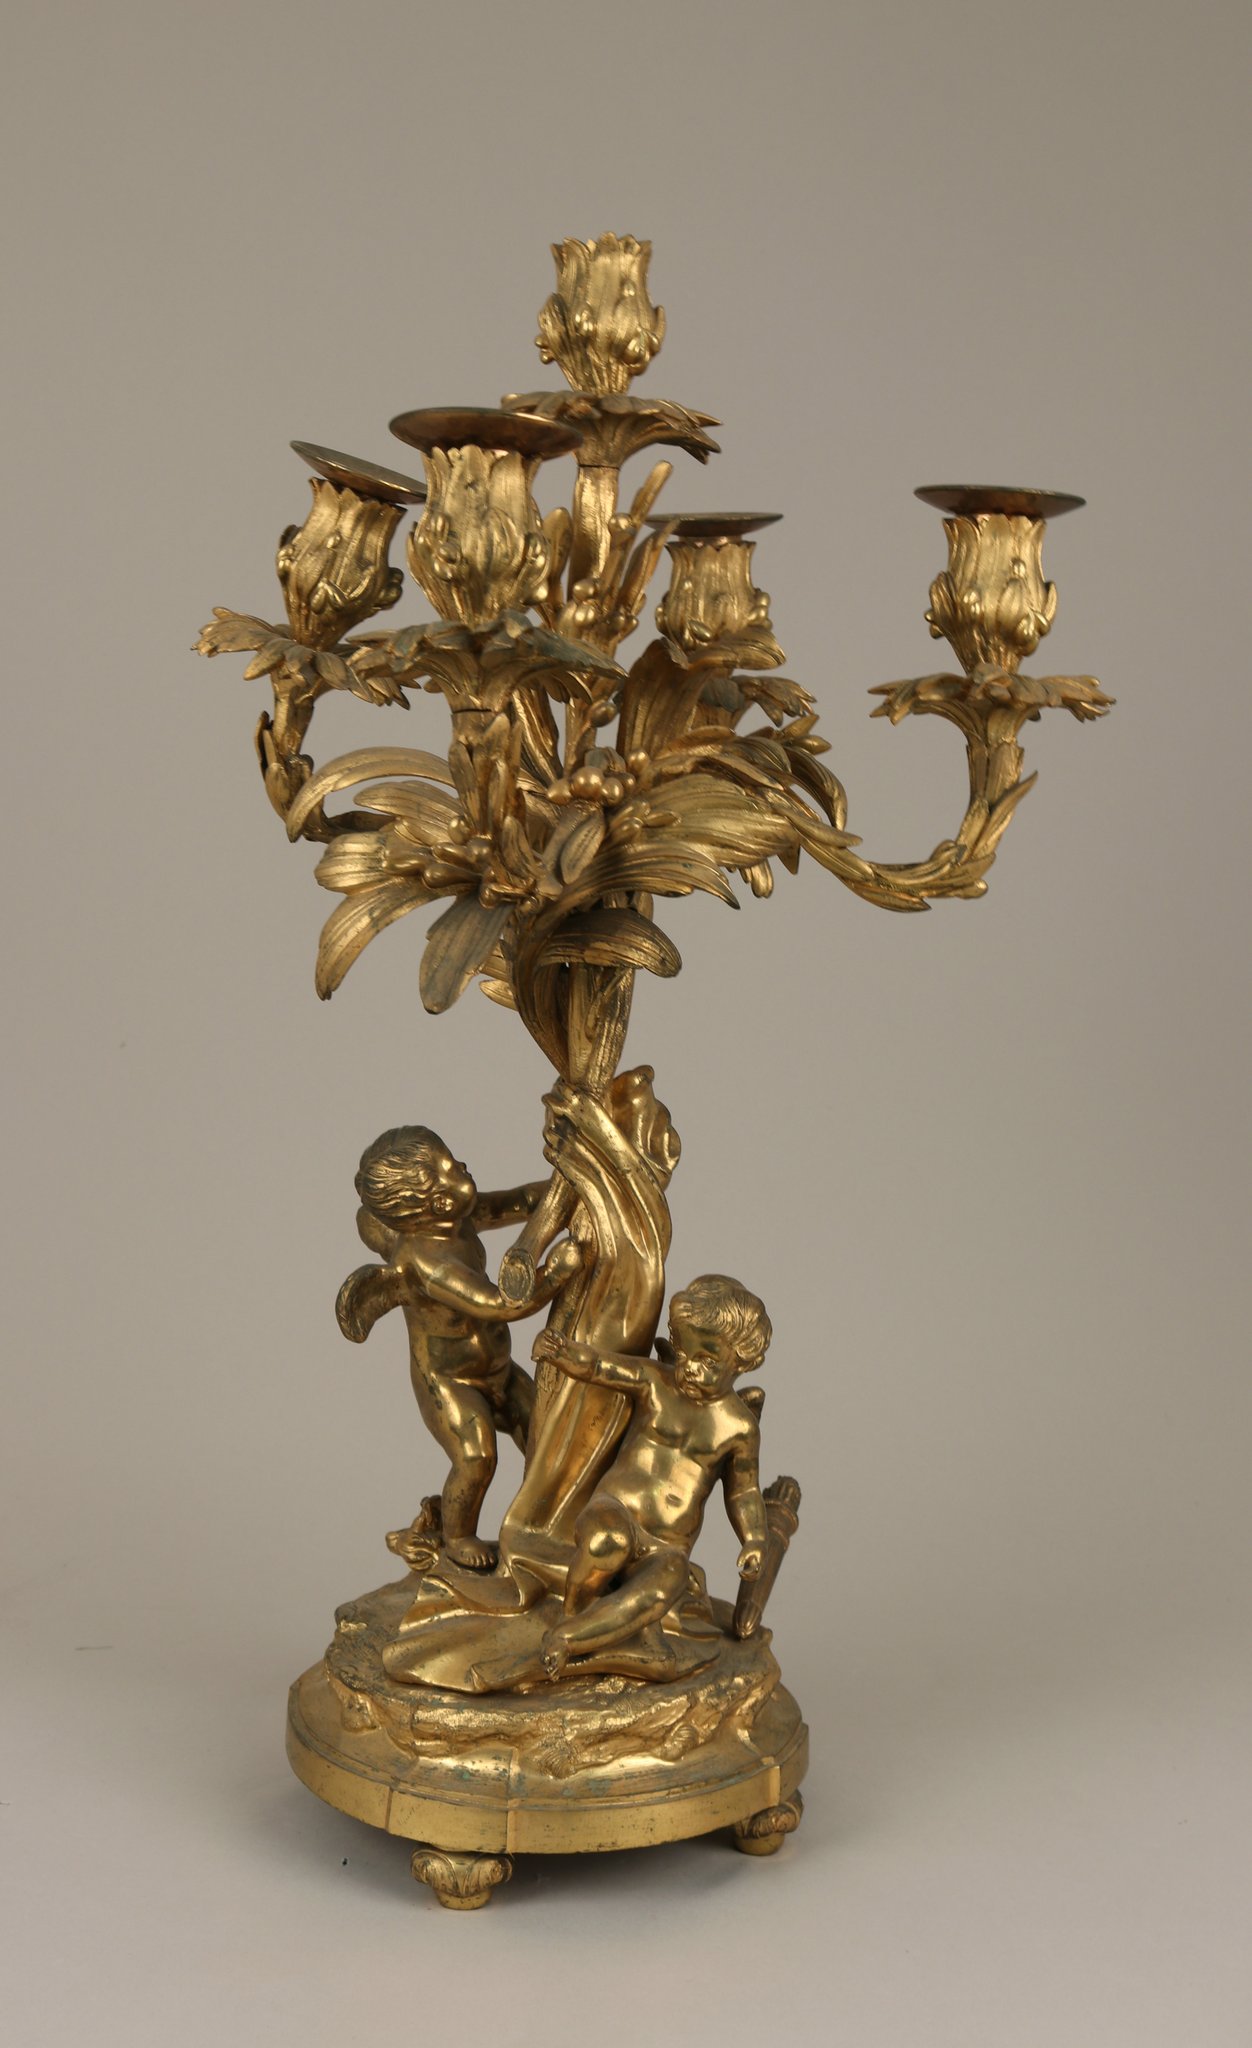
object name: candelabrum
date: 1801-1900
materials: metal, silver gilt